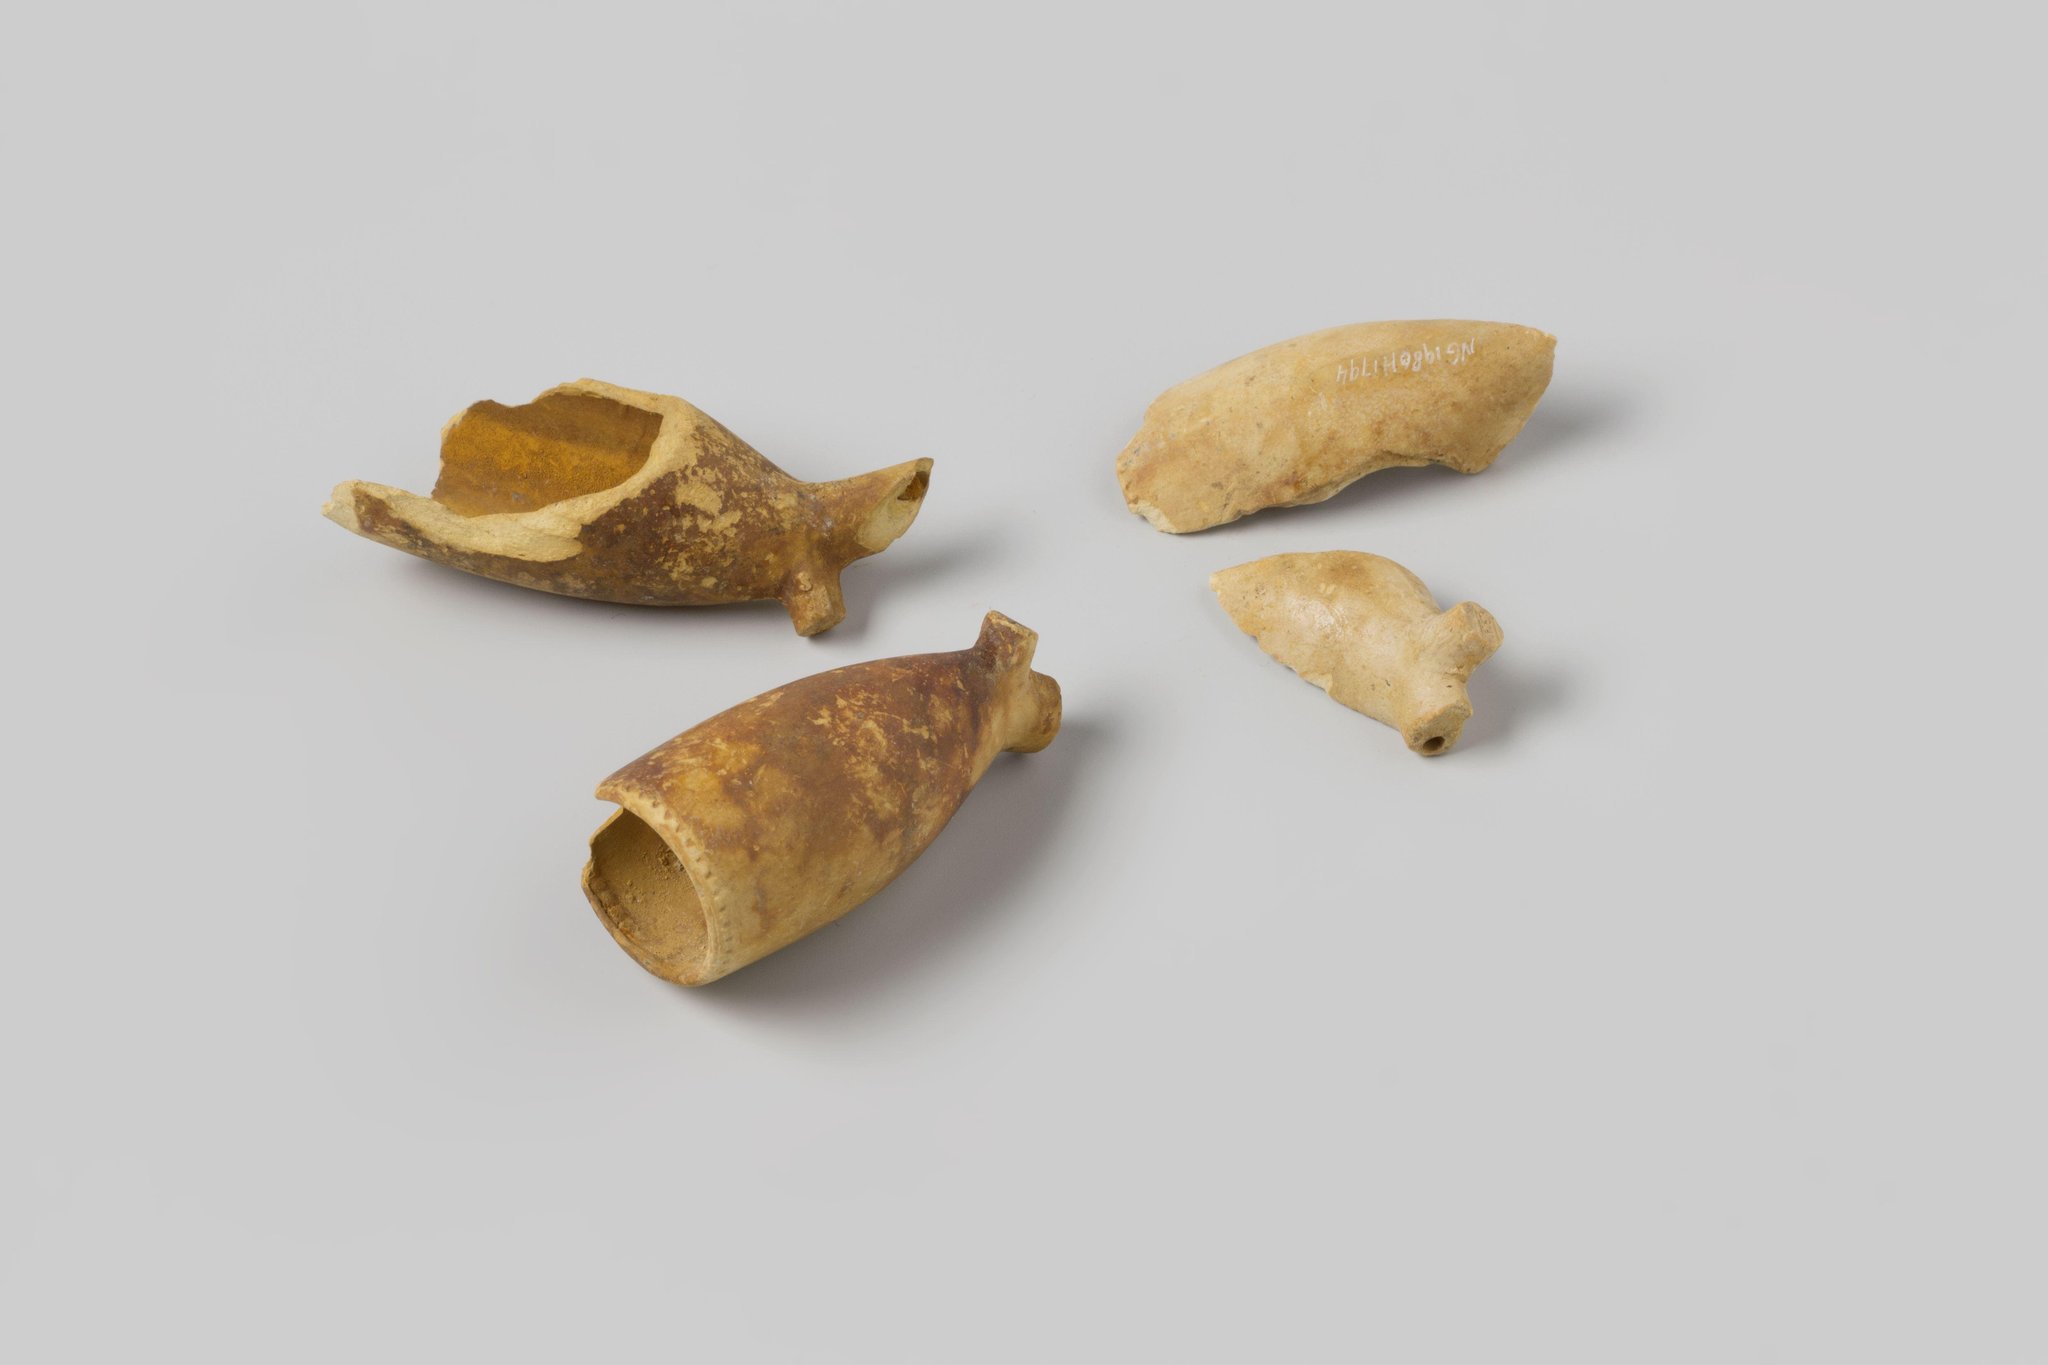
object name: pipe bowl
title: Fragmenten pijpenkoppen uit het wrak van de Oost-Indiëvaarder Hollandia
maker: Anonymous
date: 1700-1743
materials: stone, clay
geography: netherlands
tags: verenigde oostindische compagnie, hollandia (schip), annet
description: Pipe, bowl, heelmark: coat of arms of the city of Amsterdam; fragm, 2hsm1, 2hsm1,2.